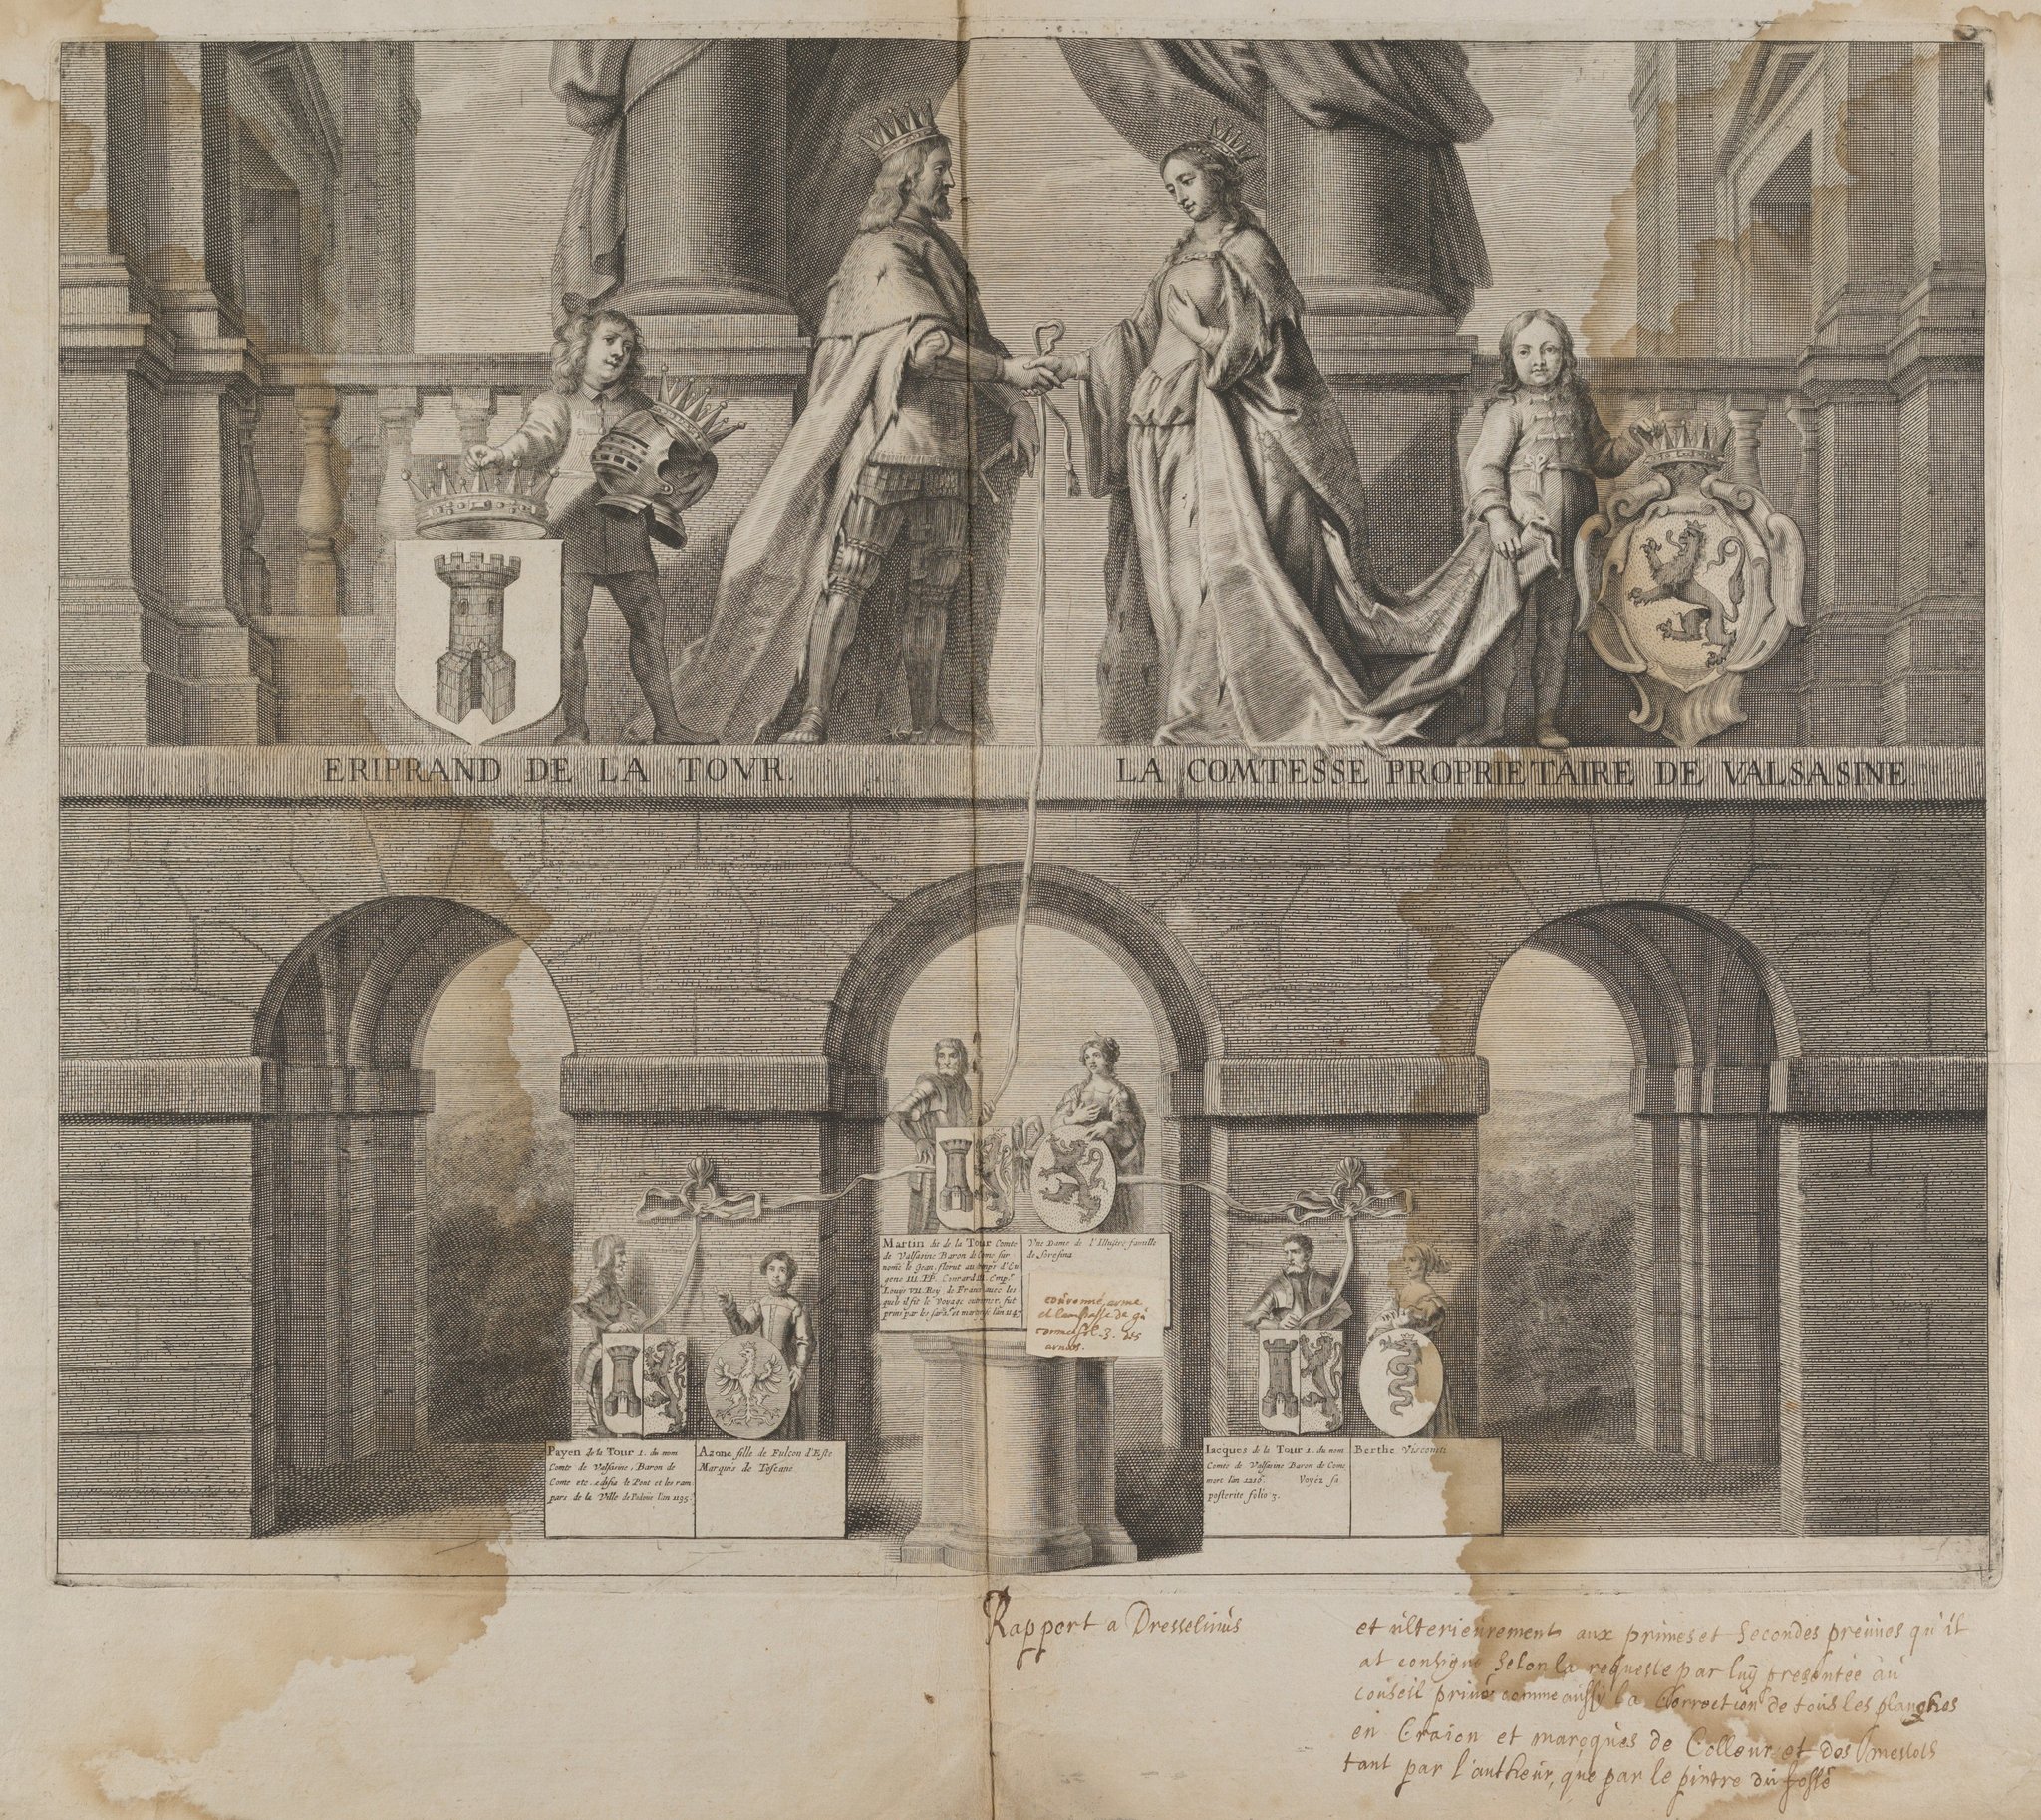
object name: print ornament architecture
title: Proof impression with Corrections and Instructions of a Print celebrating the Union and Lineage of Eriprand de la Tour with the Comtesse de Valsasine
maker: anonymous, french, 17th century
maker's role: artist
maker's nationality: french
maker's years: 1600-1700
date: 1601-1700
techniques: engraving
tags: boys,men,women,coat of arms